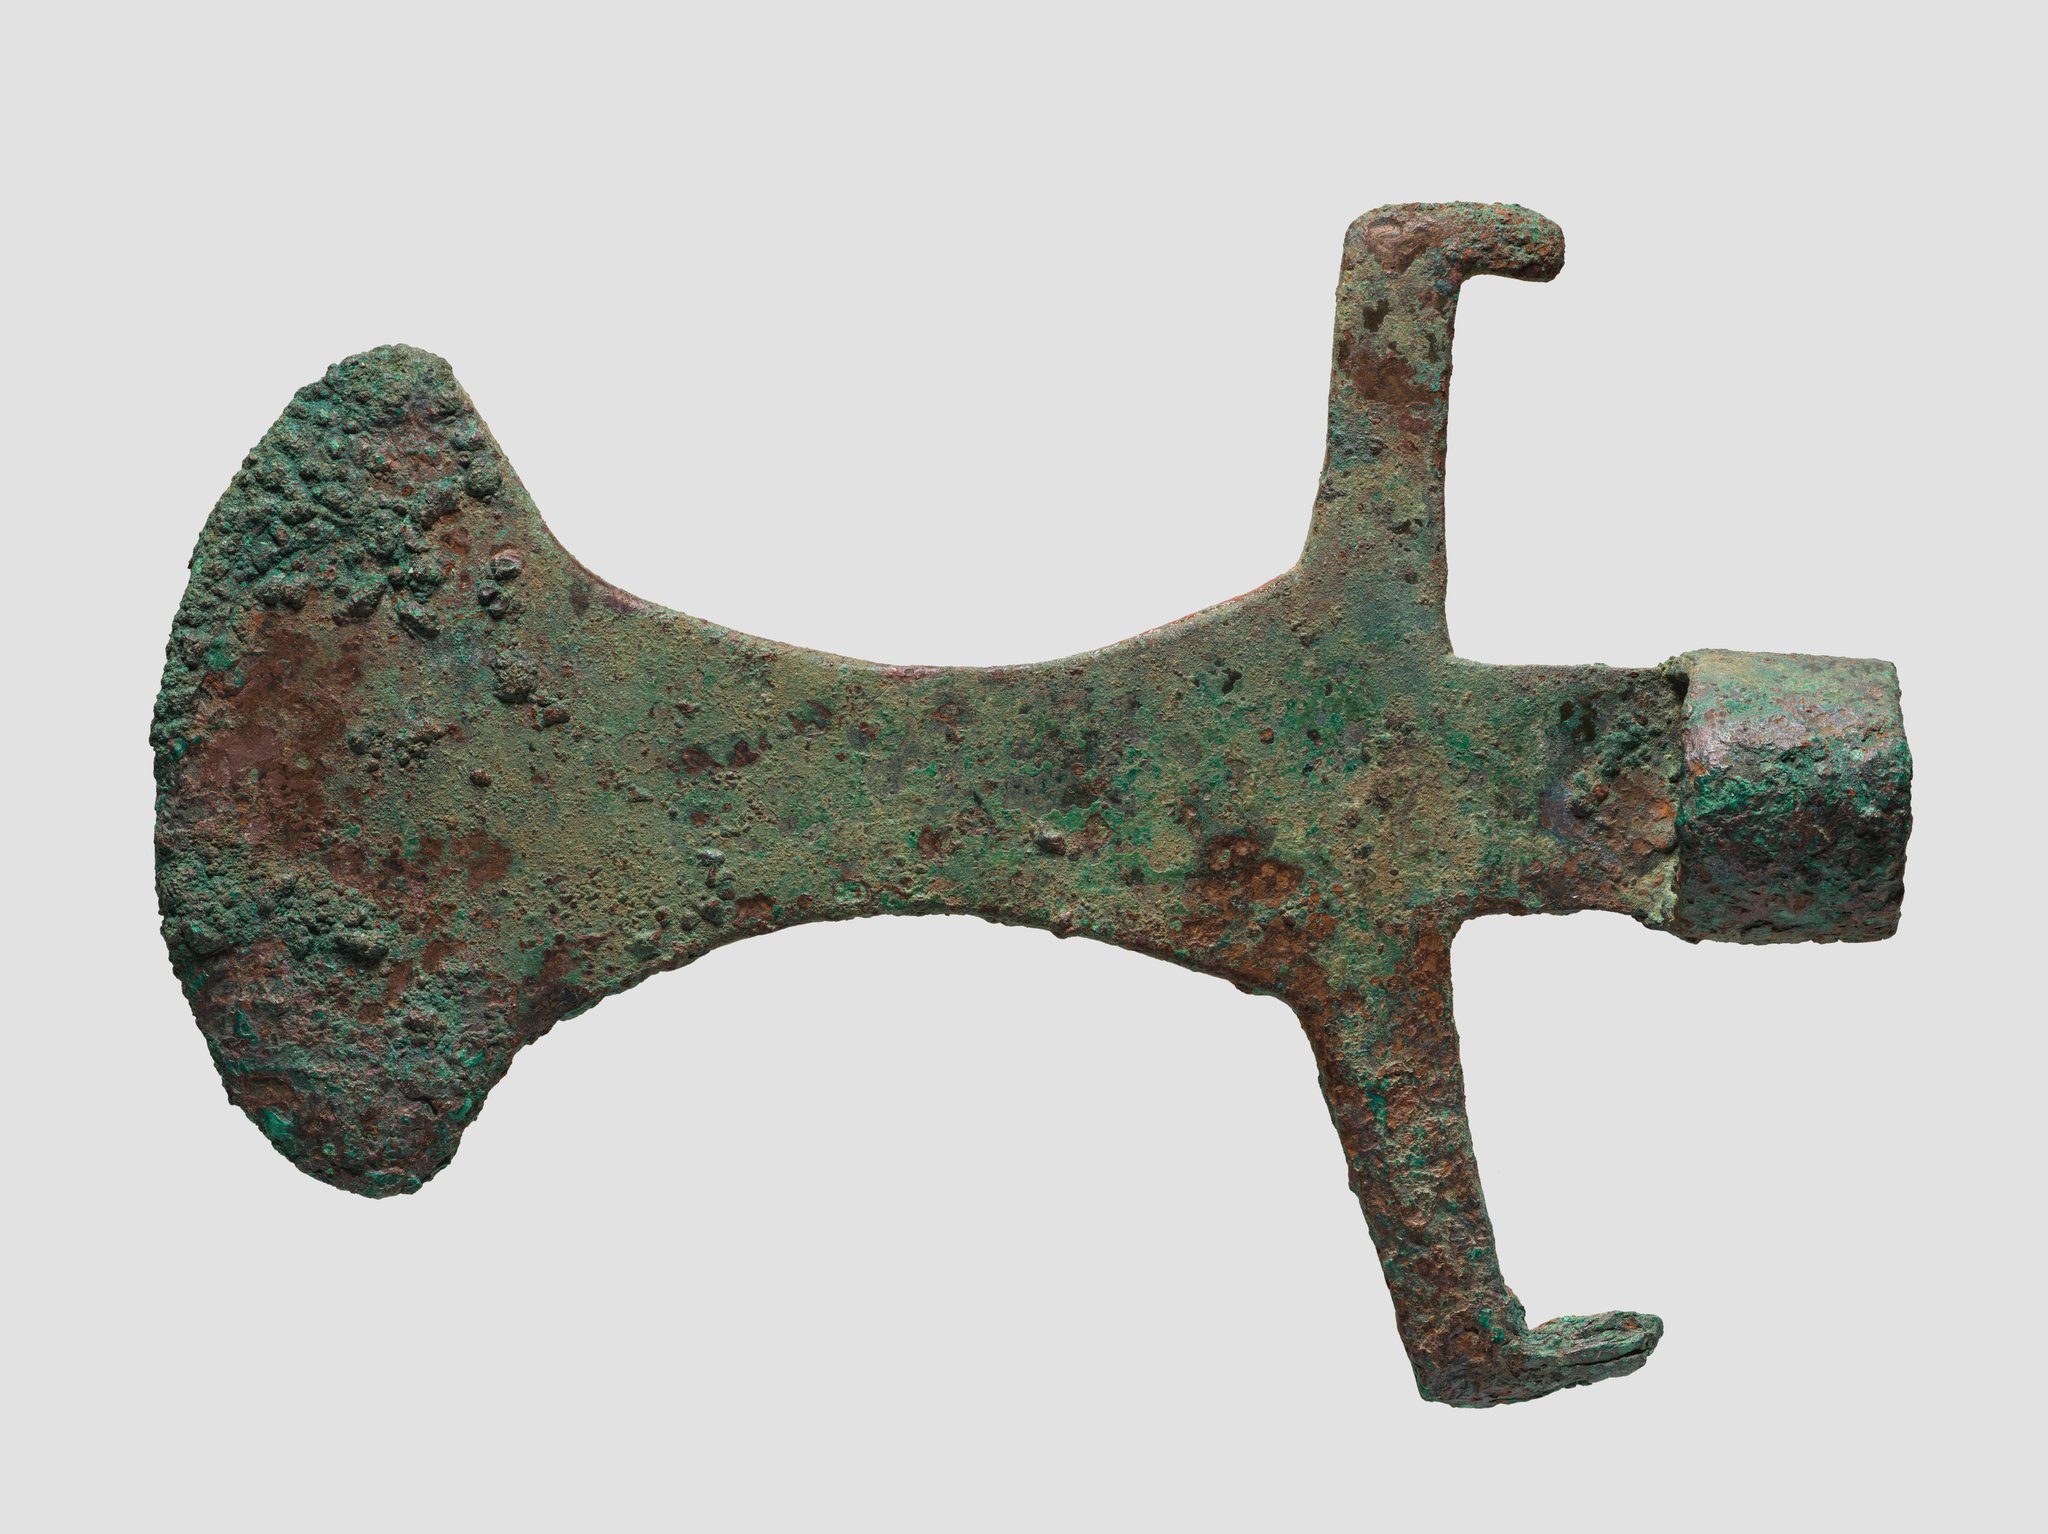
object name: axe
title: Axe blade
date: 1000-668 BCE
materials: bronze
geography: transcaucasia